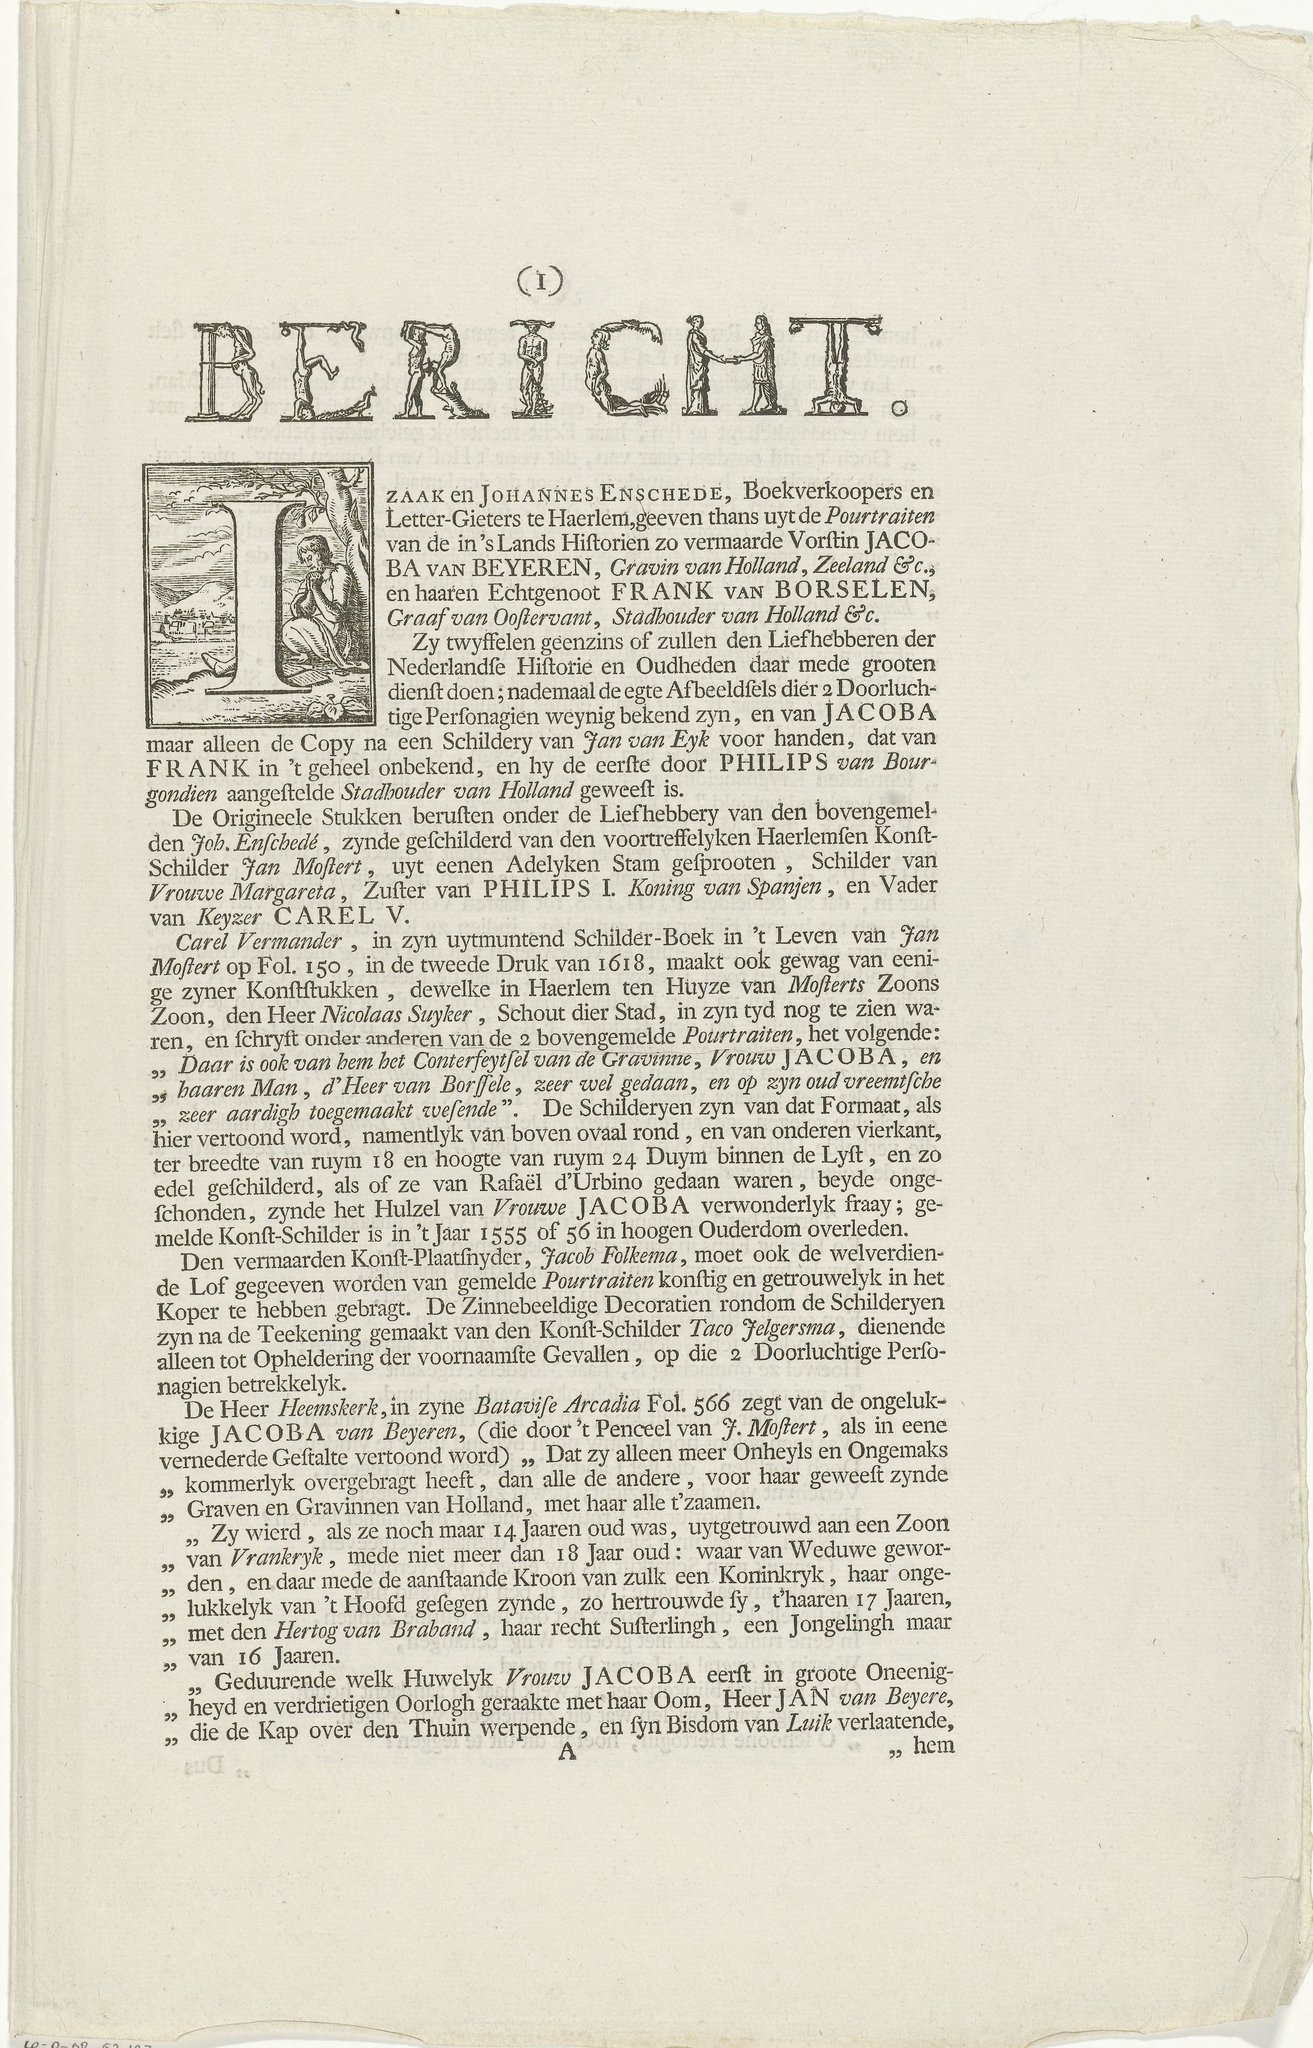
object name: text sheet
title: Aankondiging van de portretten van Jacoba van Beieren en Frank van Borselen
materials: paper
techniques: letterpress printing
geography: haarlem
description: Twee aan weerszijden bedrukte tekstbladen met houtsneden, dienend als aankondiging van de uitgave van de portretten van Jacoba van Beieren en Frank van Borselen, vervaardigd door prentmaker Jacob Folkema.